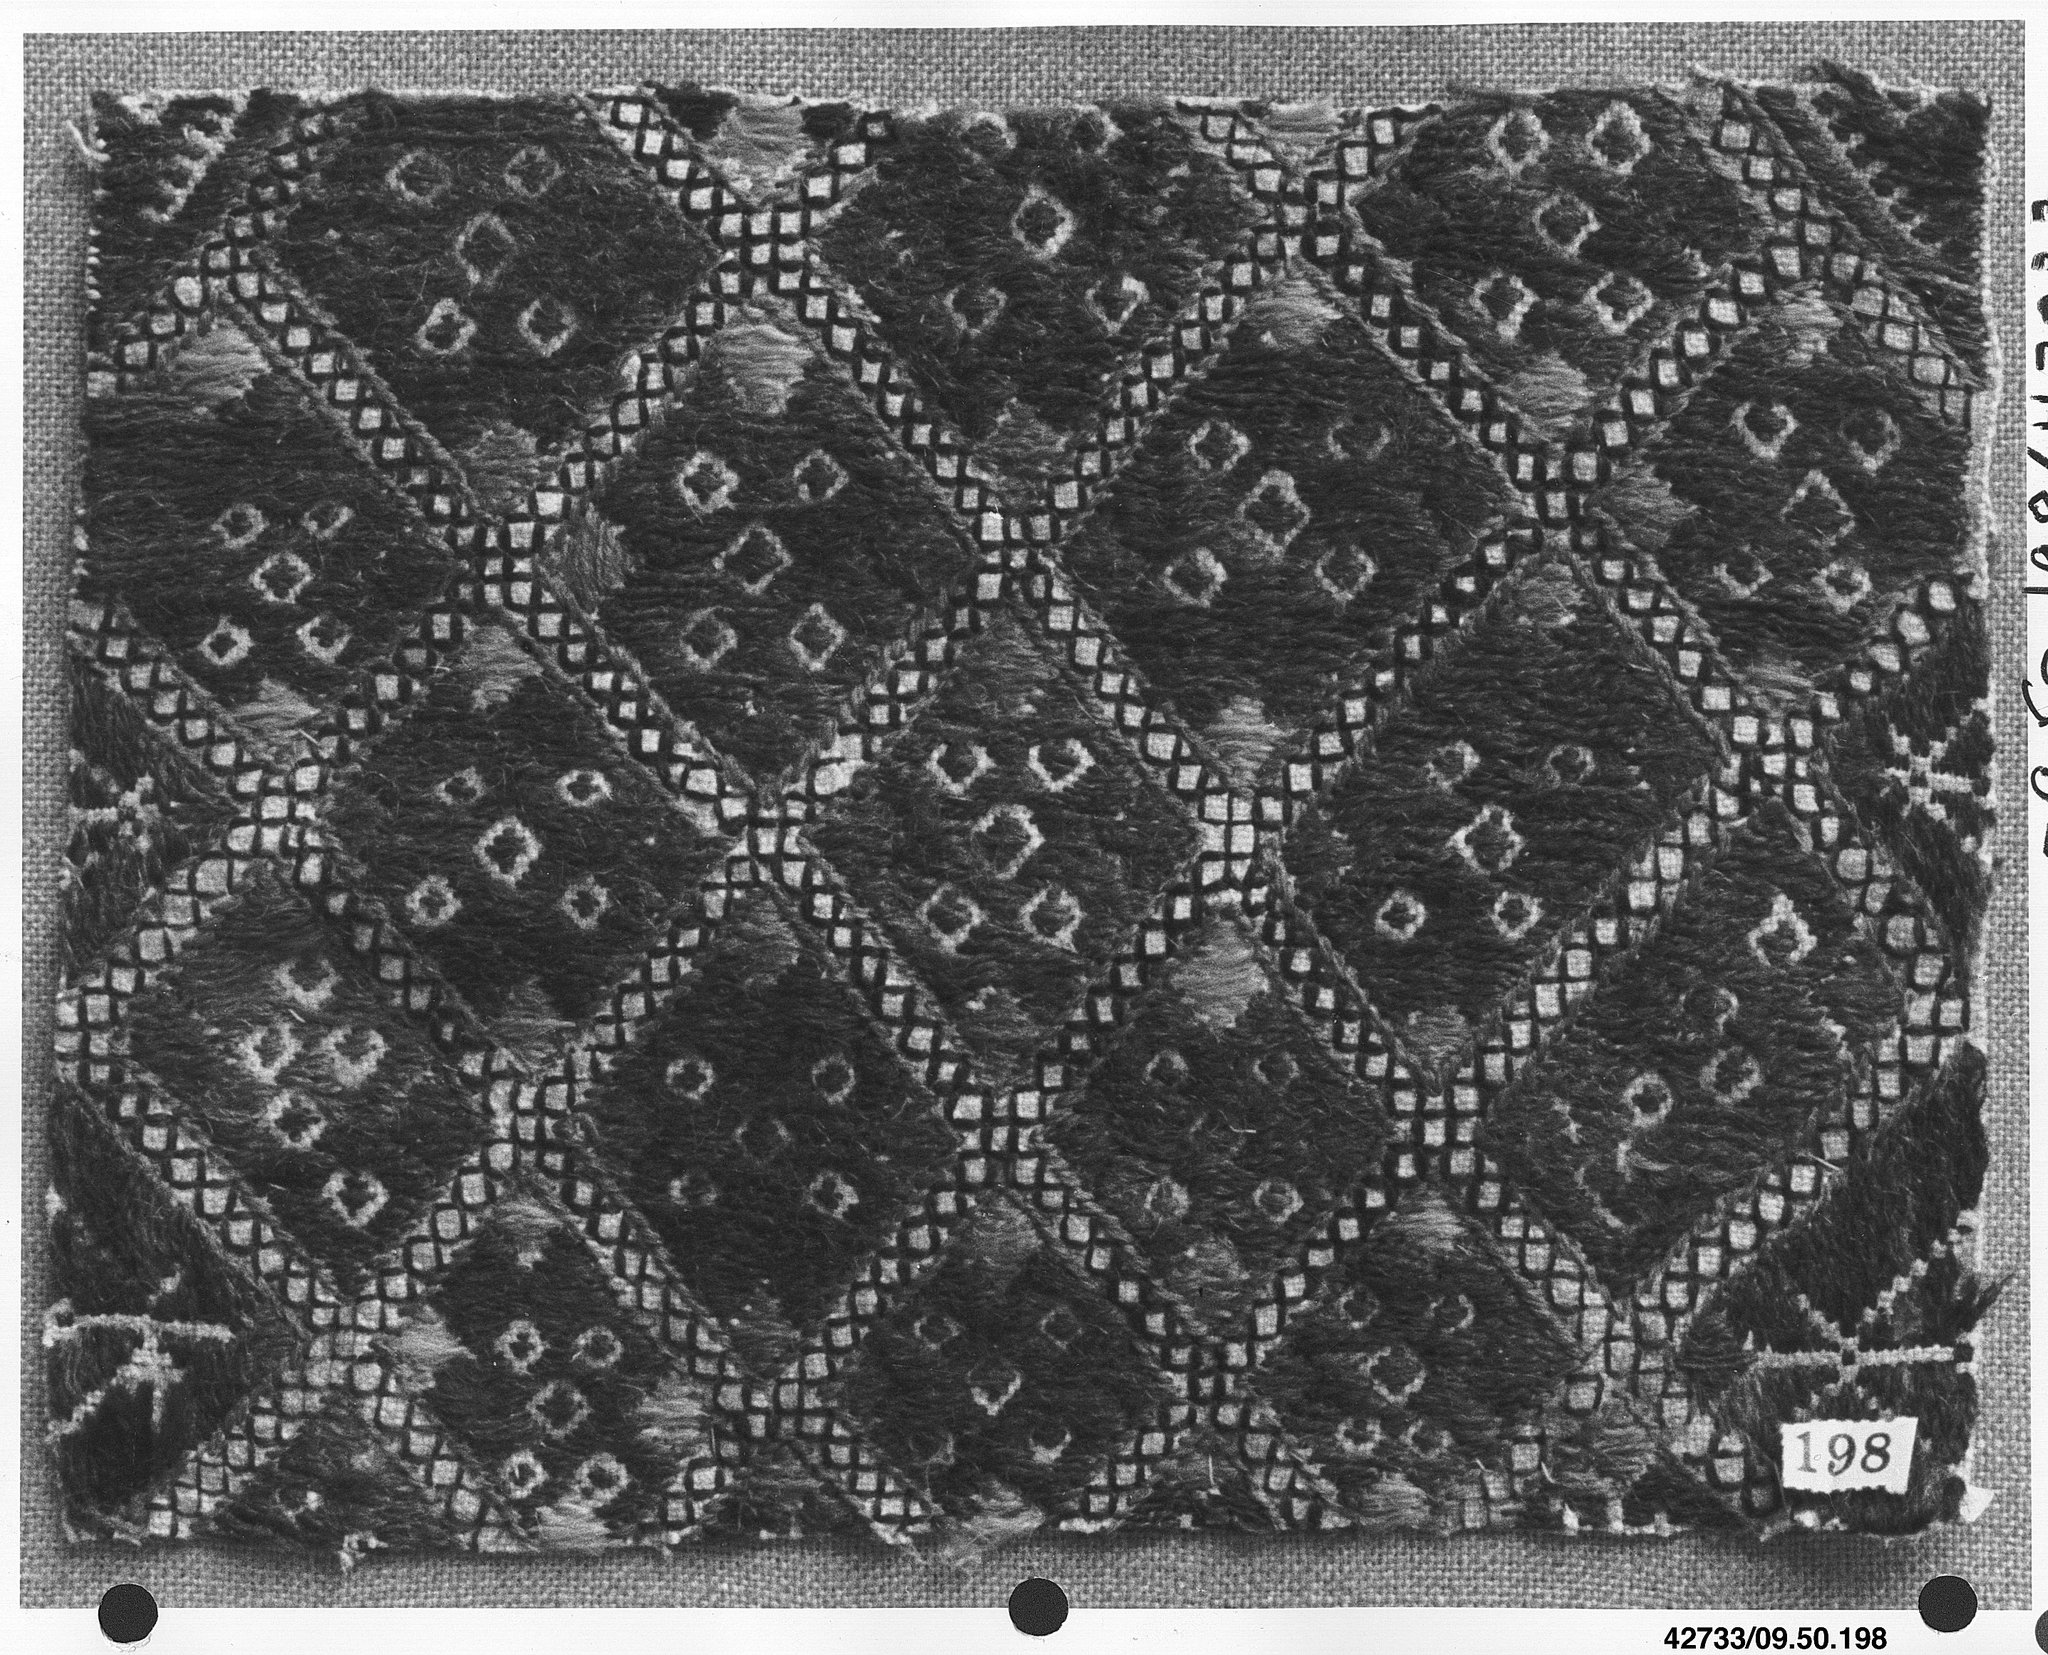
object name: costume fragment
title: Peasant costume fragment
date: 1701-1900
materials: canvas, wool